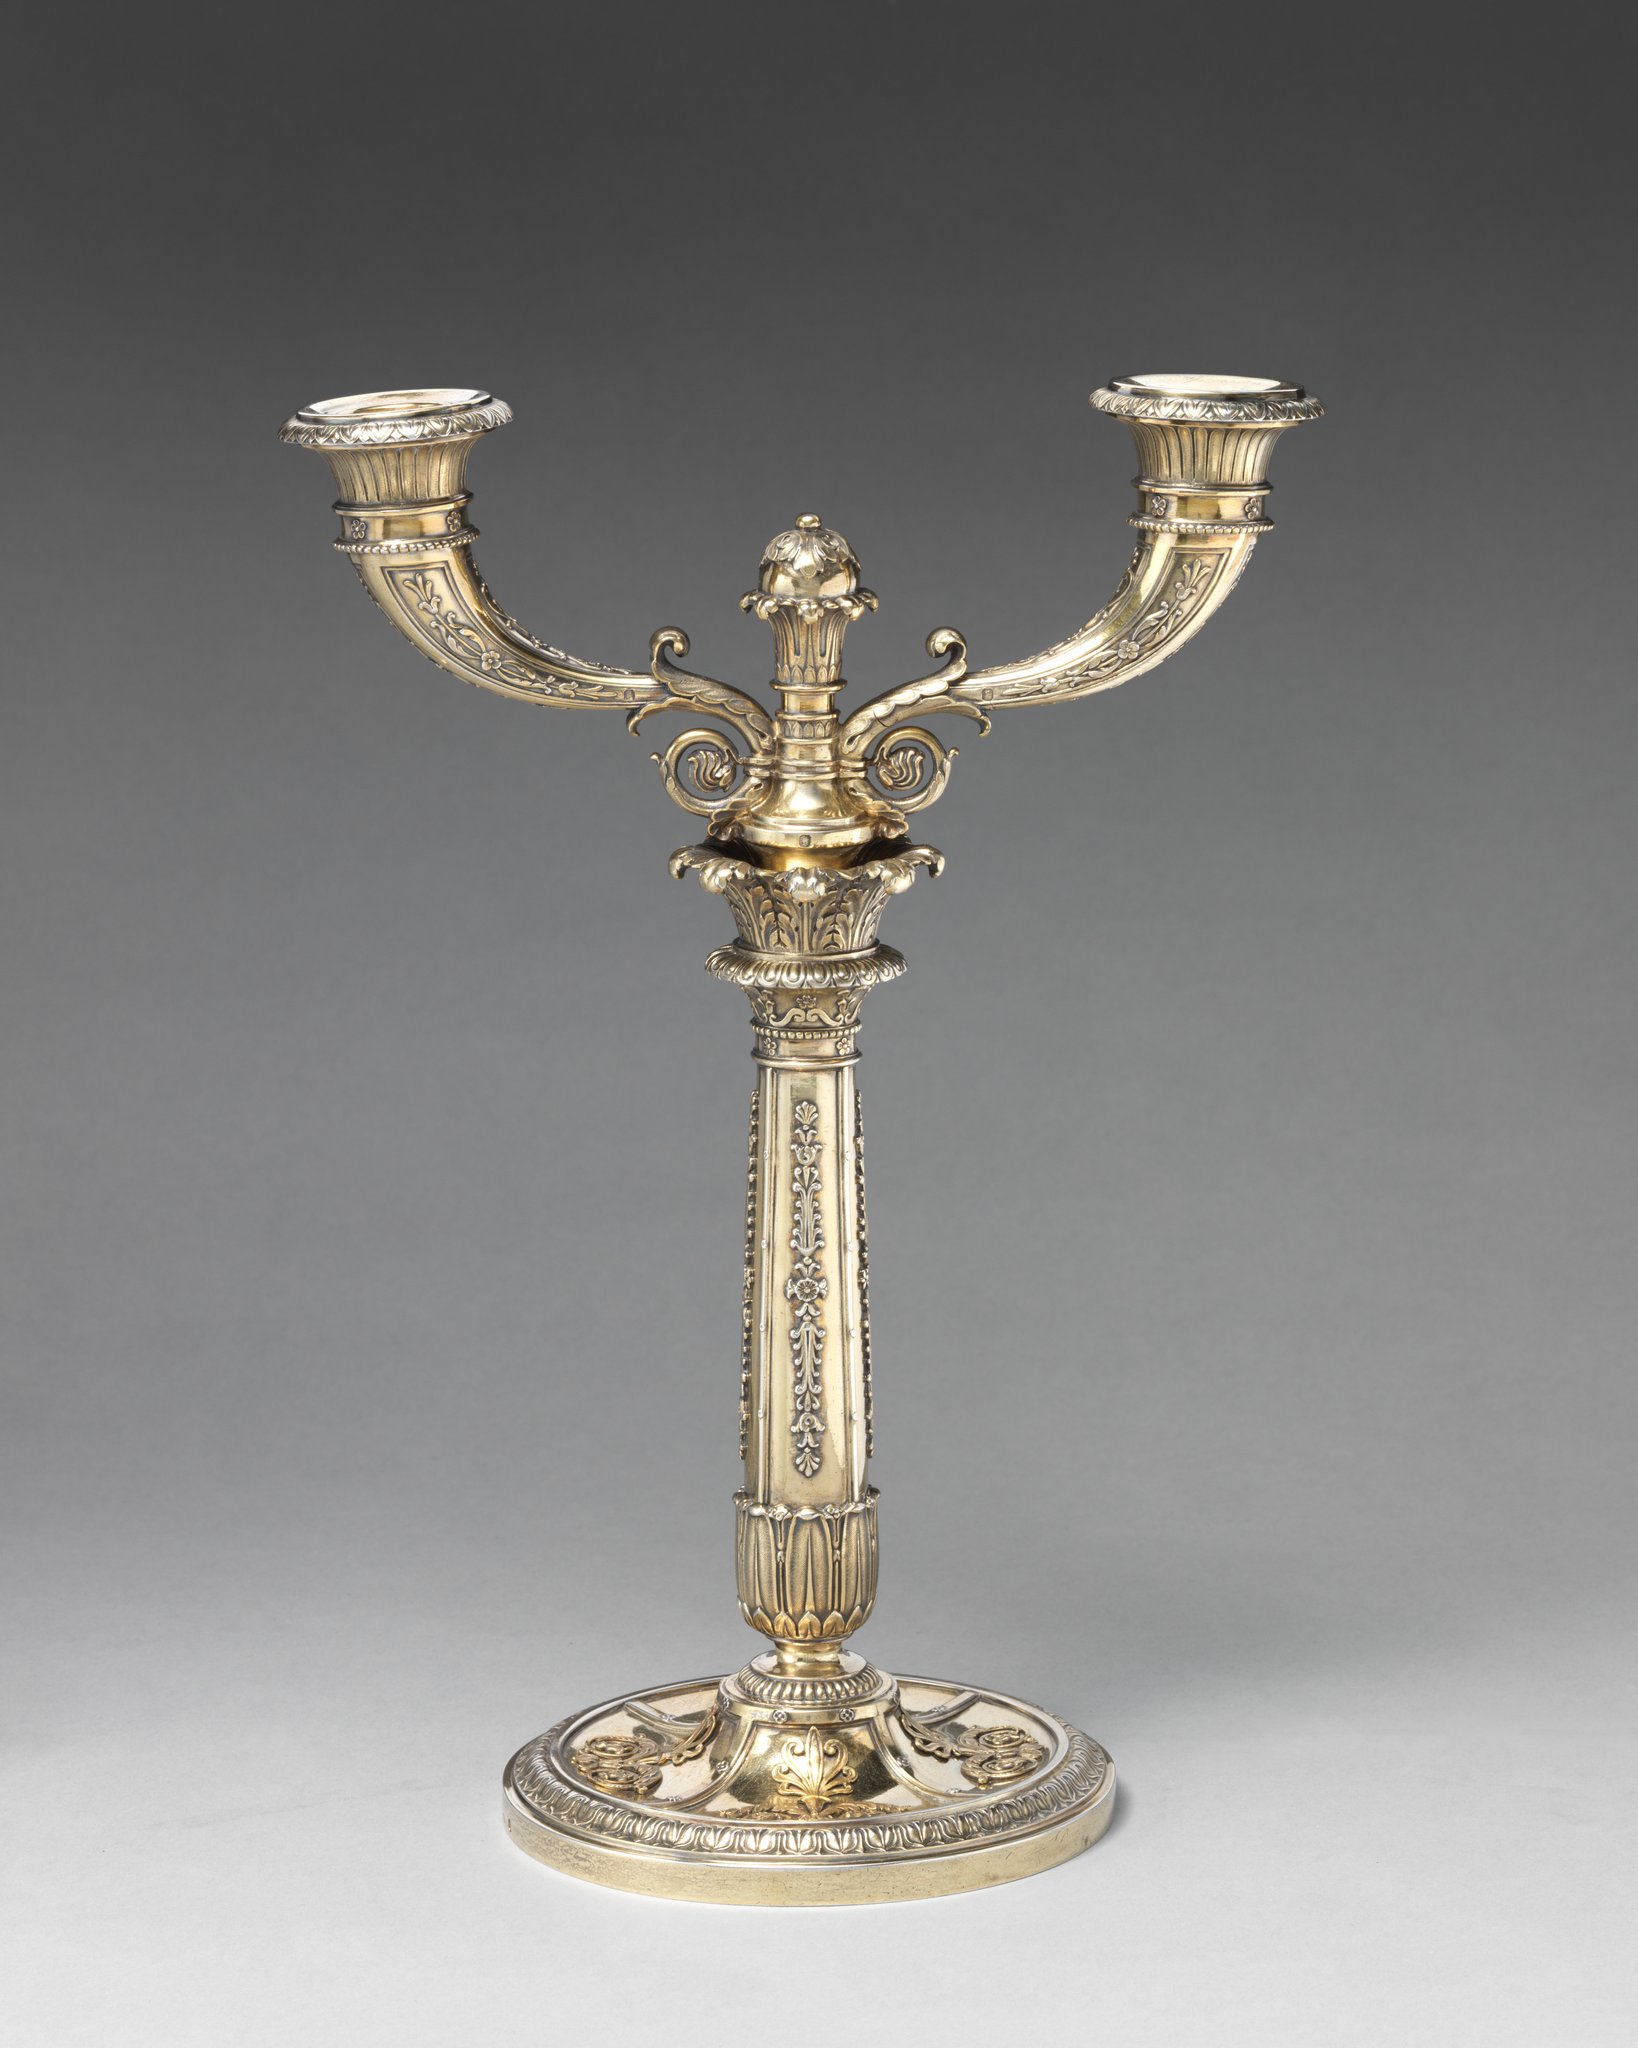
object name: two branch candelabra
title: Two-branch candelabra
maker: andré aucoc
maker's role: maker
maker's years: 1825-1925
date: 1887-1911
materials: mother of pearl, silver gilt